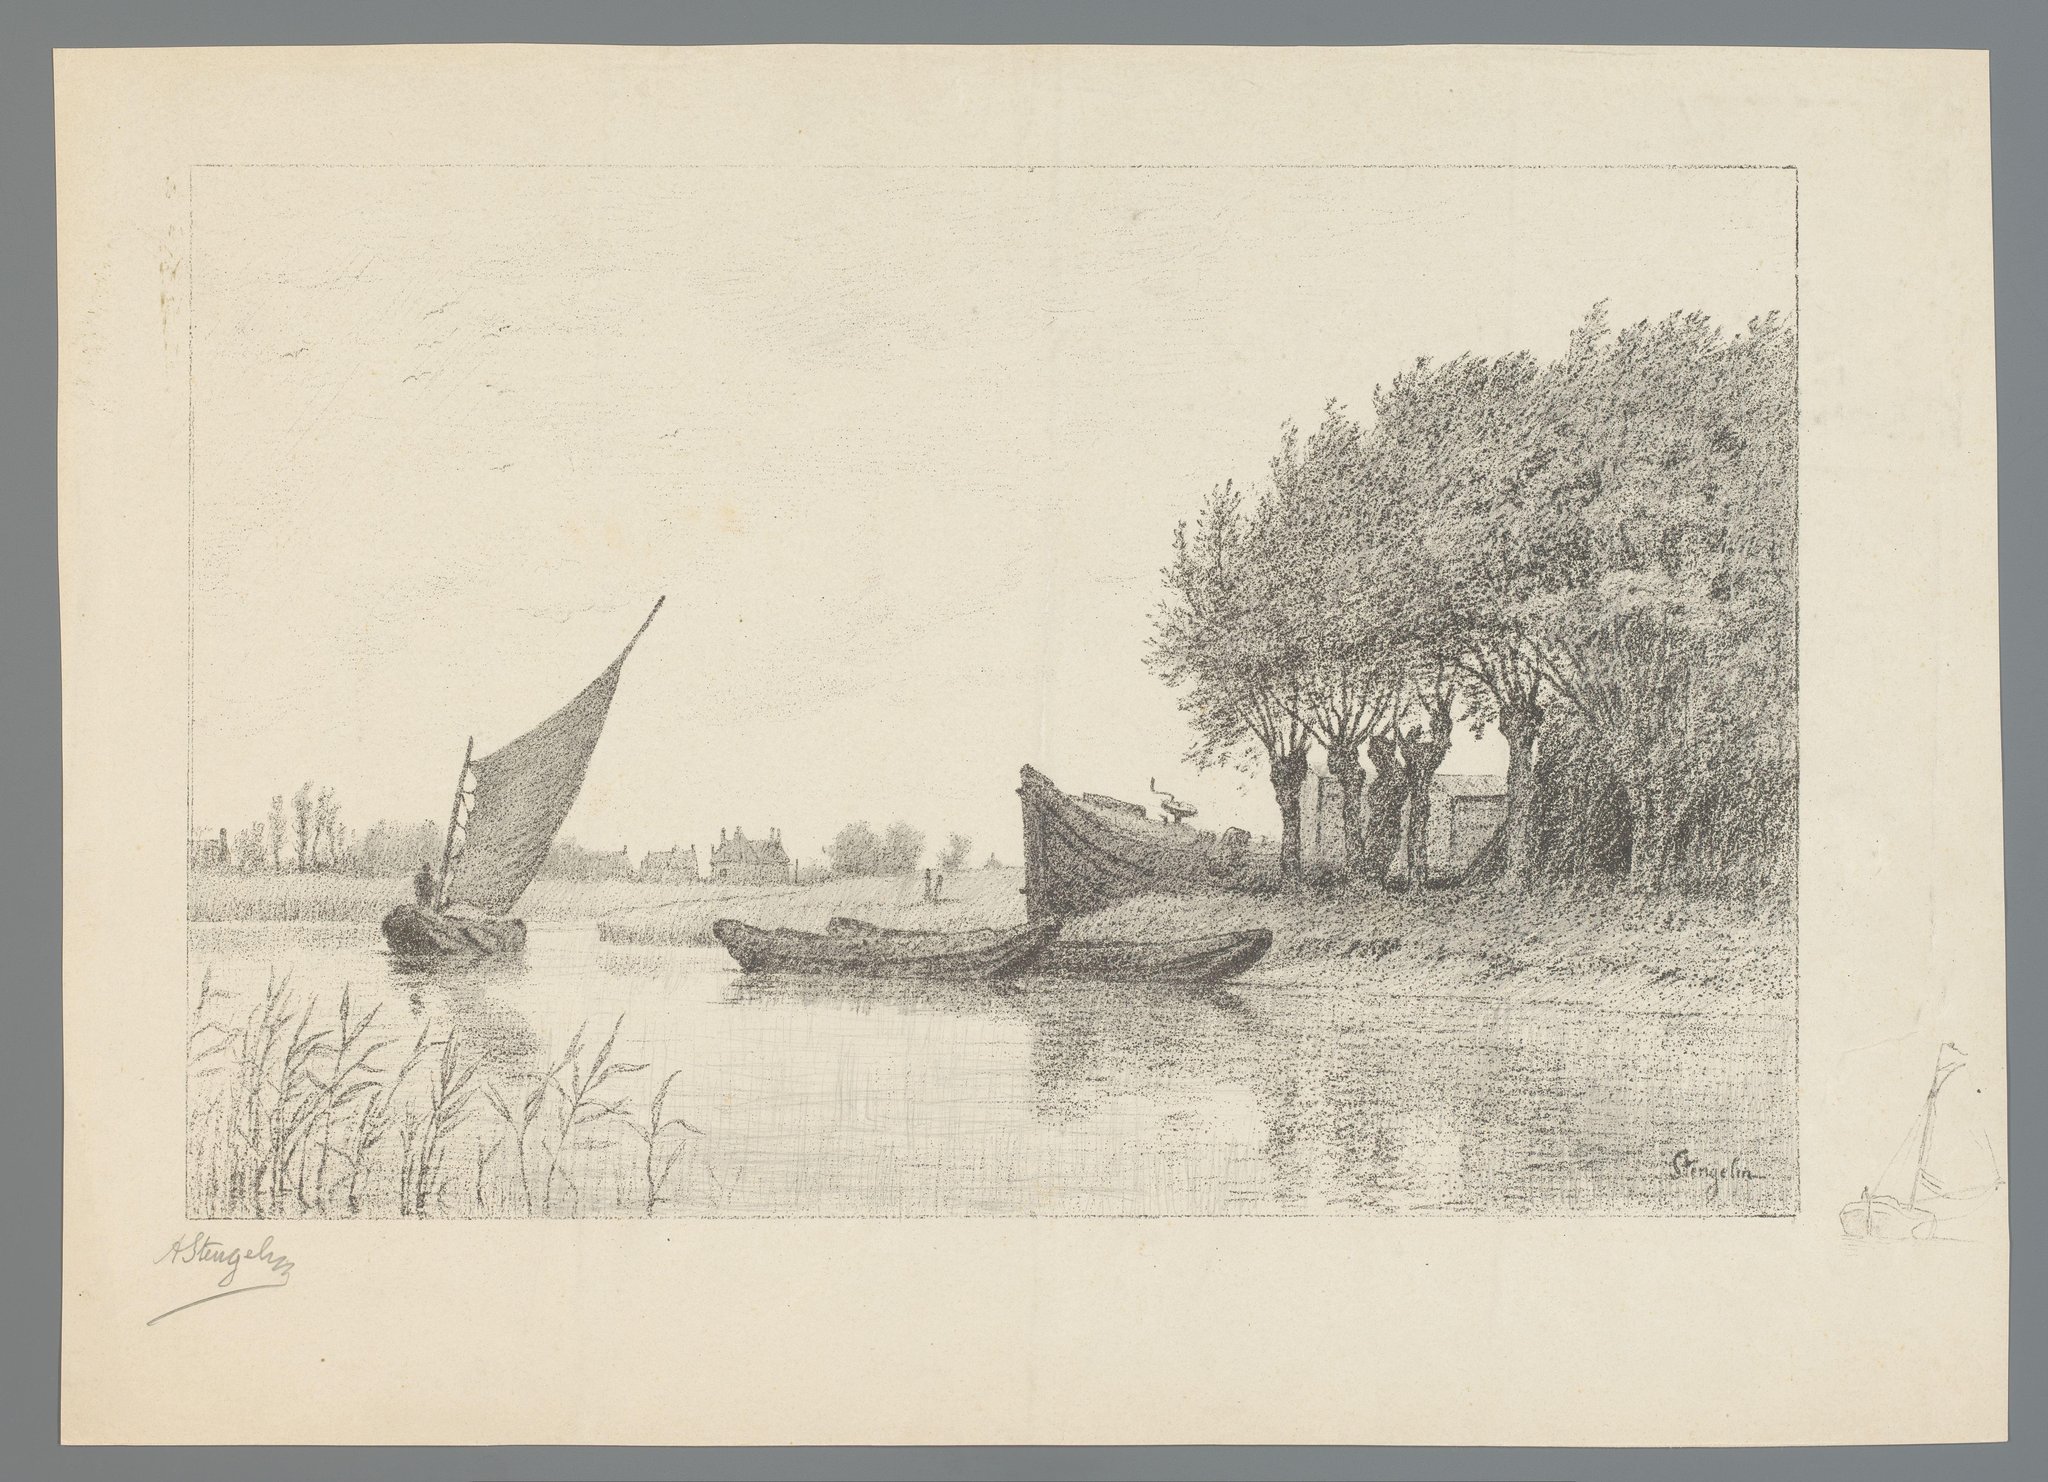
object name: print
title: Schepen op de vaart bij Papendrecht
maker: alphonse stengelin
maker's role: painter, print maker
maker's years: 1852-1938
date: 1876-1910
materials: paper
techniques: lithograph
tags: canal, ships (in general)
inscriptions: collector's mark: Lugt 2228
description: Rechtsonder een remarque met een zeilboot.